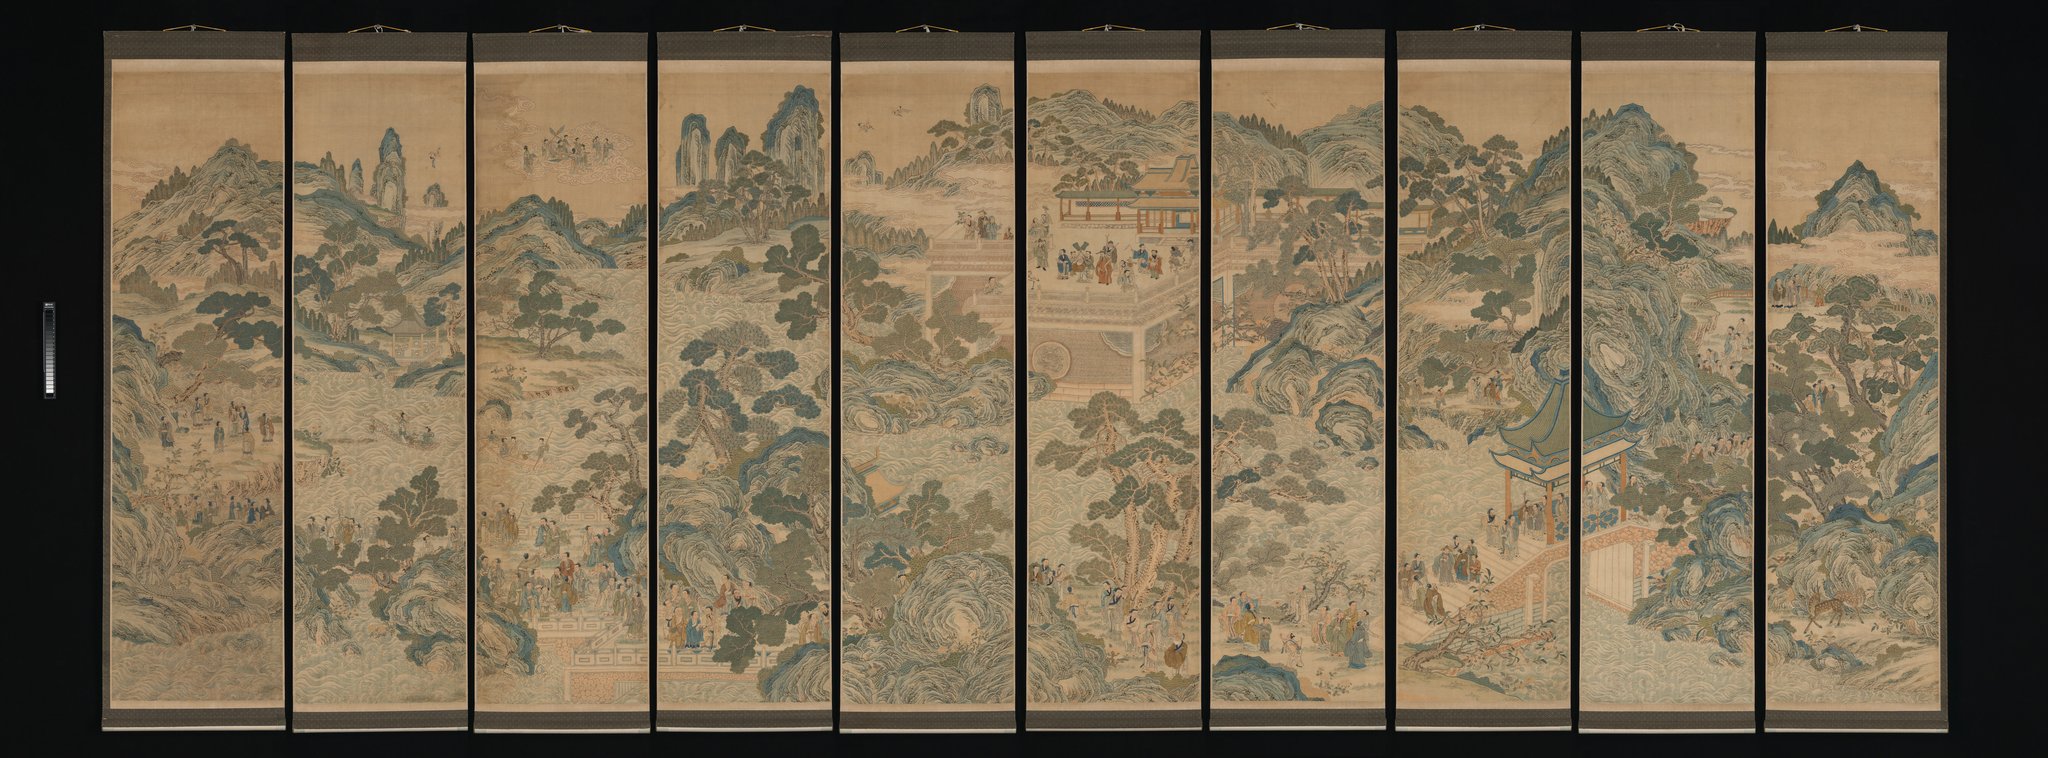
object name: hanging scroll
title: Mythical landscape with immortals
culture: chinese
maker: unidentified artist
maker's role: artist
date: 1801-1900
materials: ink, silk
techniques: painting, tapestry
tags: men,women,landscapes